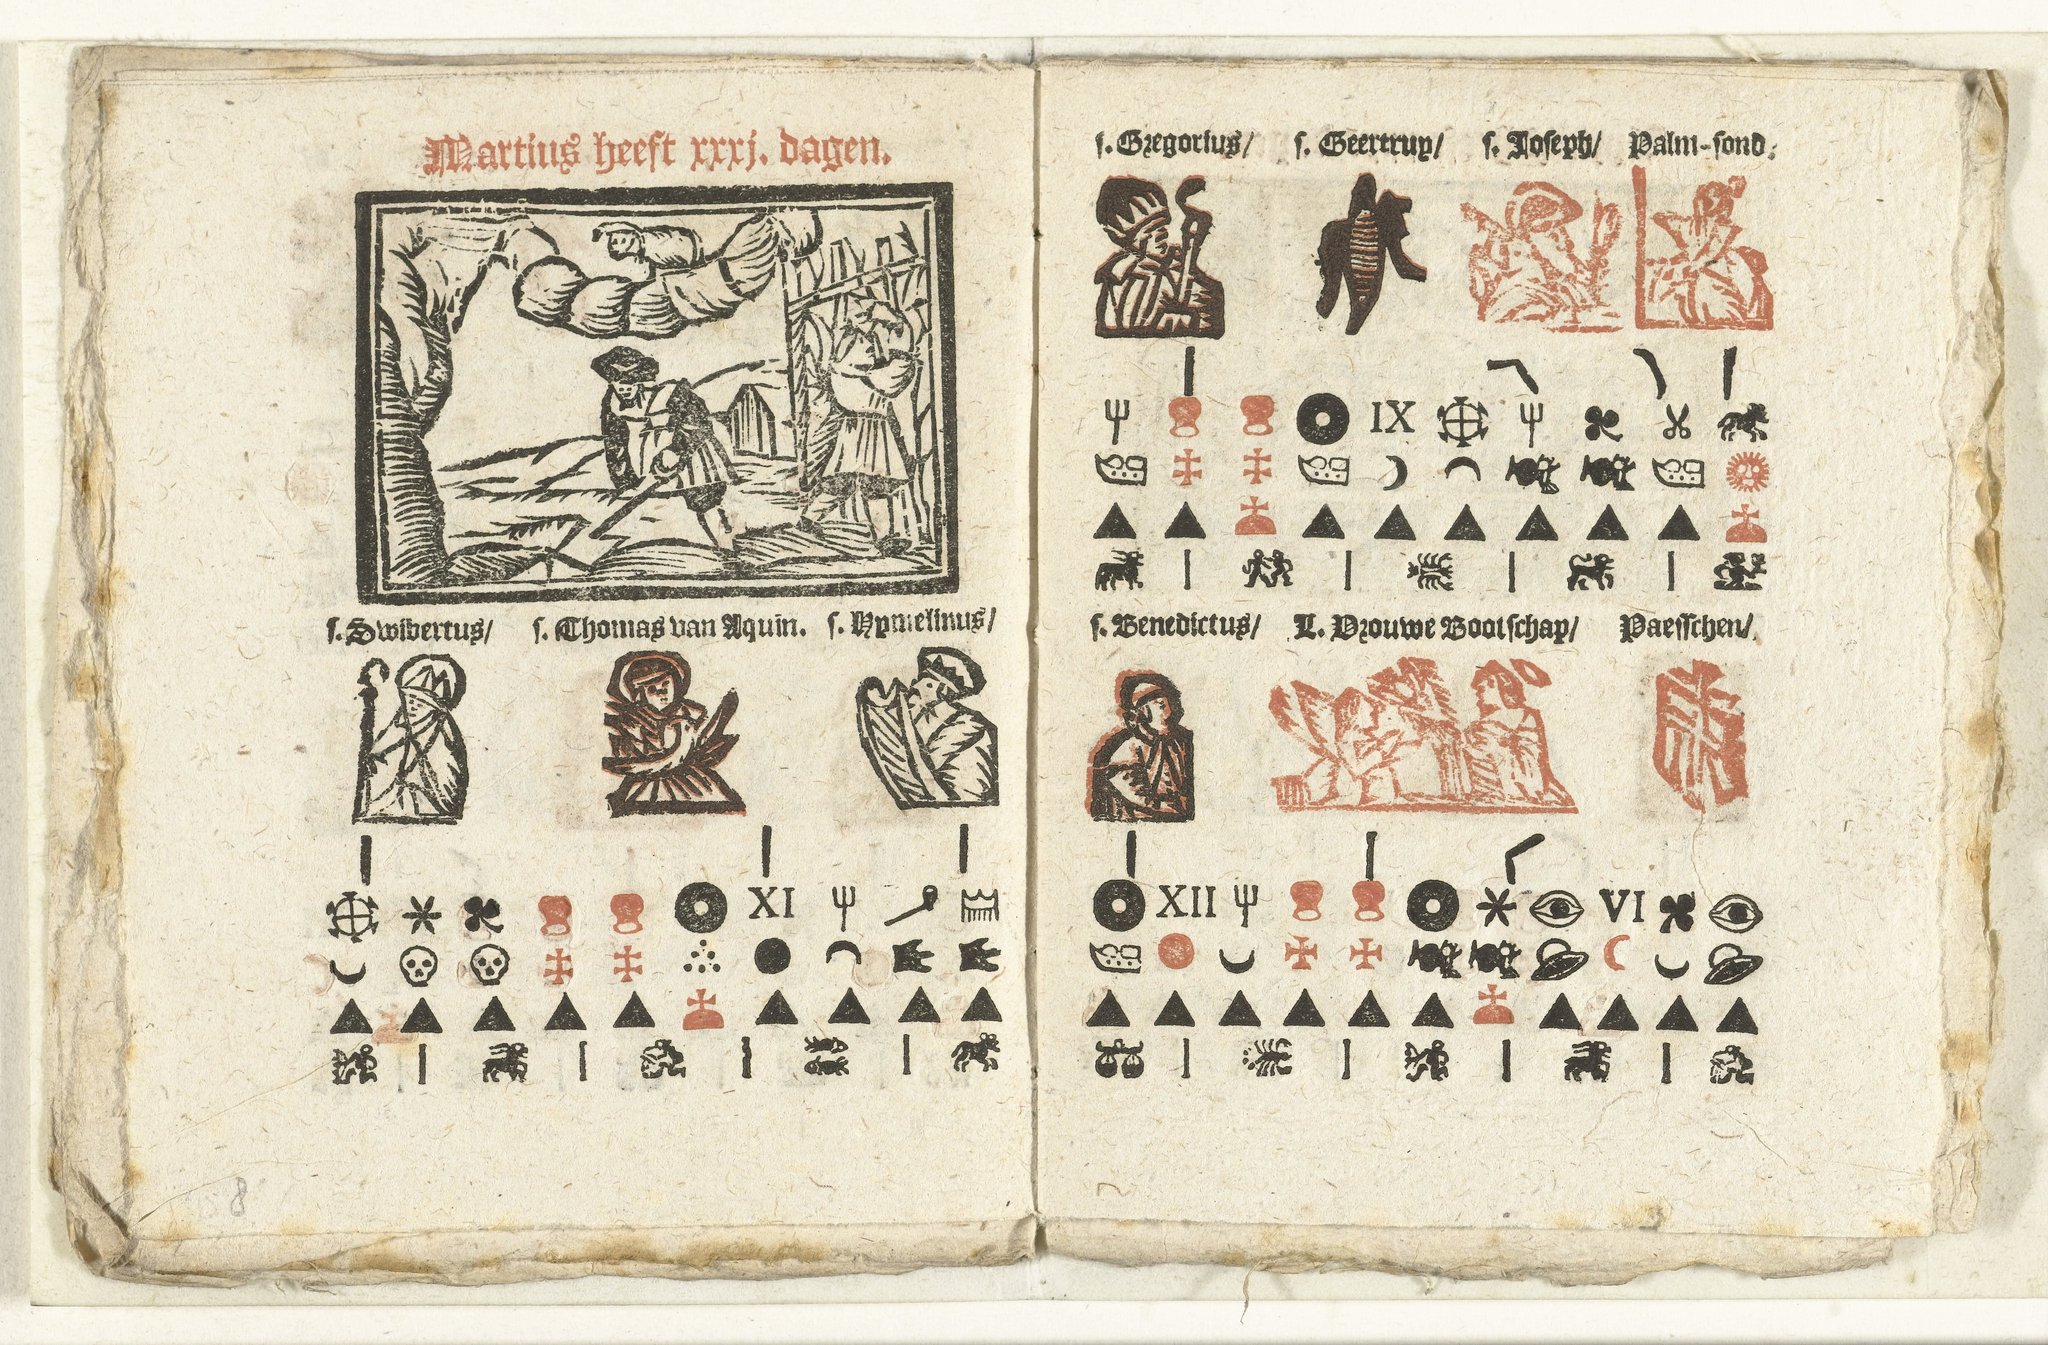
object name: book illustration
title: Bladzijden met de voorspelling voor de maand maart, 1712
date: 1712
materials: paper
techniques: letterpress printing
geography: antwerp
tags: february and its 'labours' (+ with zodiacal signs)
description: Bladzijden in: Den Boeren / Oft Schapers Almanach Voor 't Schrickel Jaer ins Heeren Jesu Christi, 1712. Antwerpen: bij Wed. Slegers 1712. Exemplaar in de Rijksmuseum Research Library (signatuur: 305 G 19).